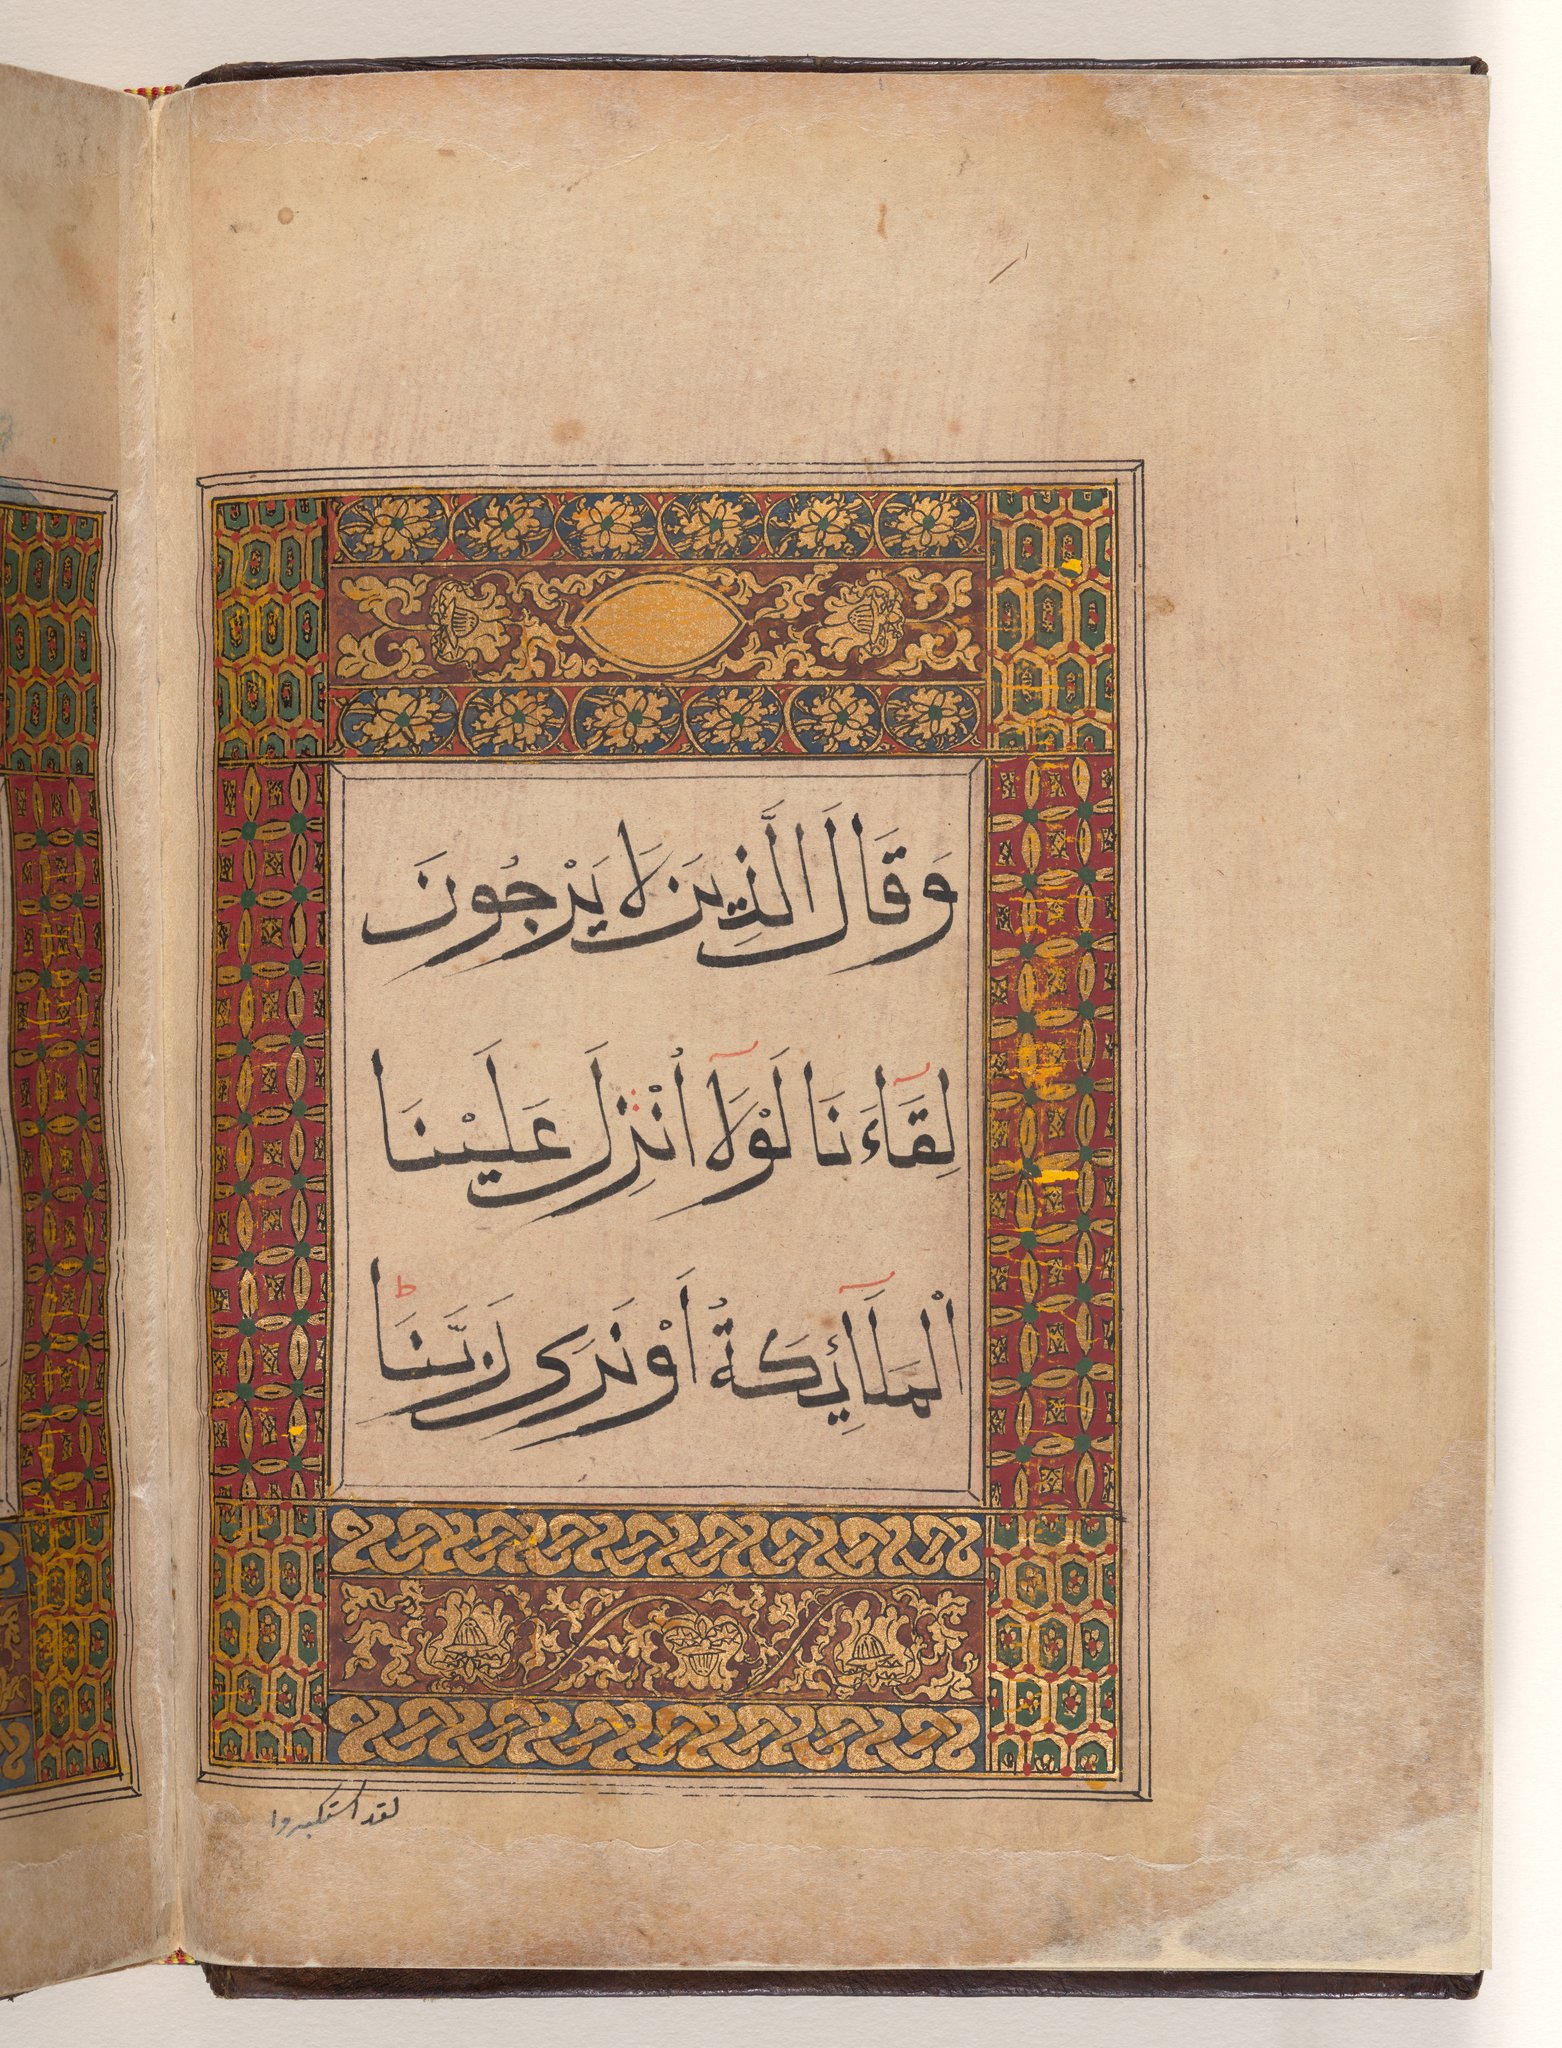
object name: non illustrated manuscript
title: Qur’an Juz' XIX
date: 1667-1800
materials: gold, ink, leather, paper, watercolor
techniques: bookbinding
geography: turkestan